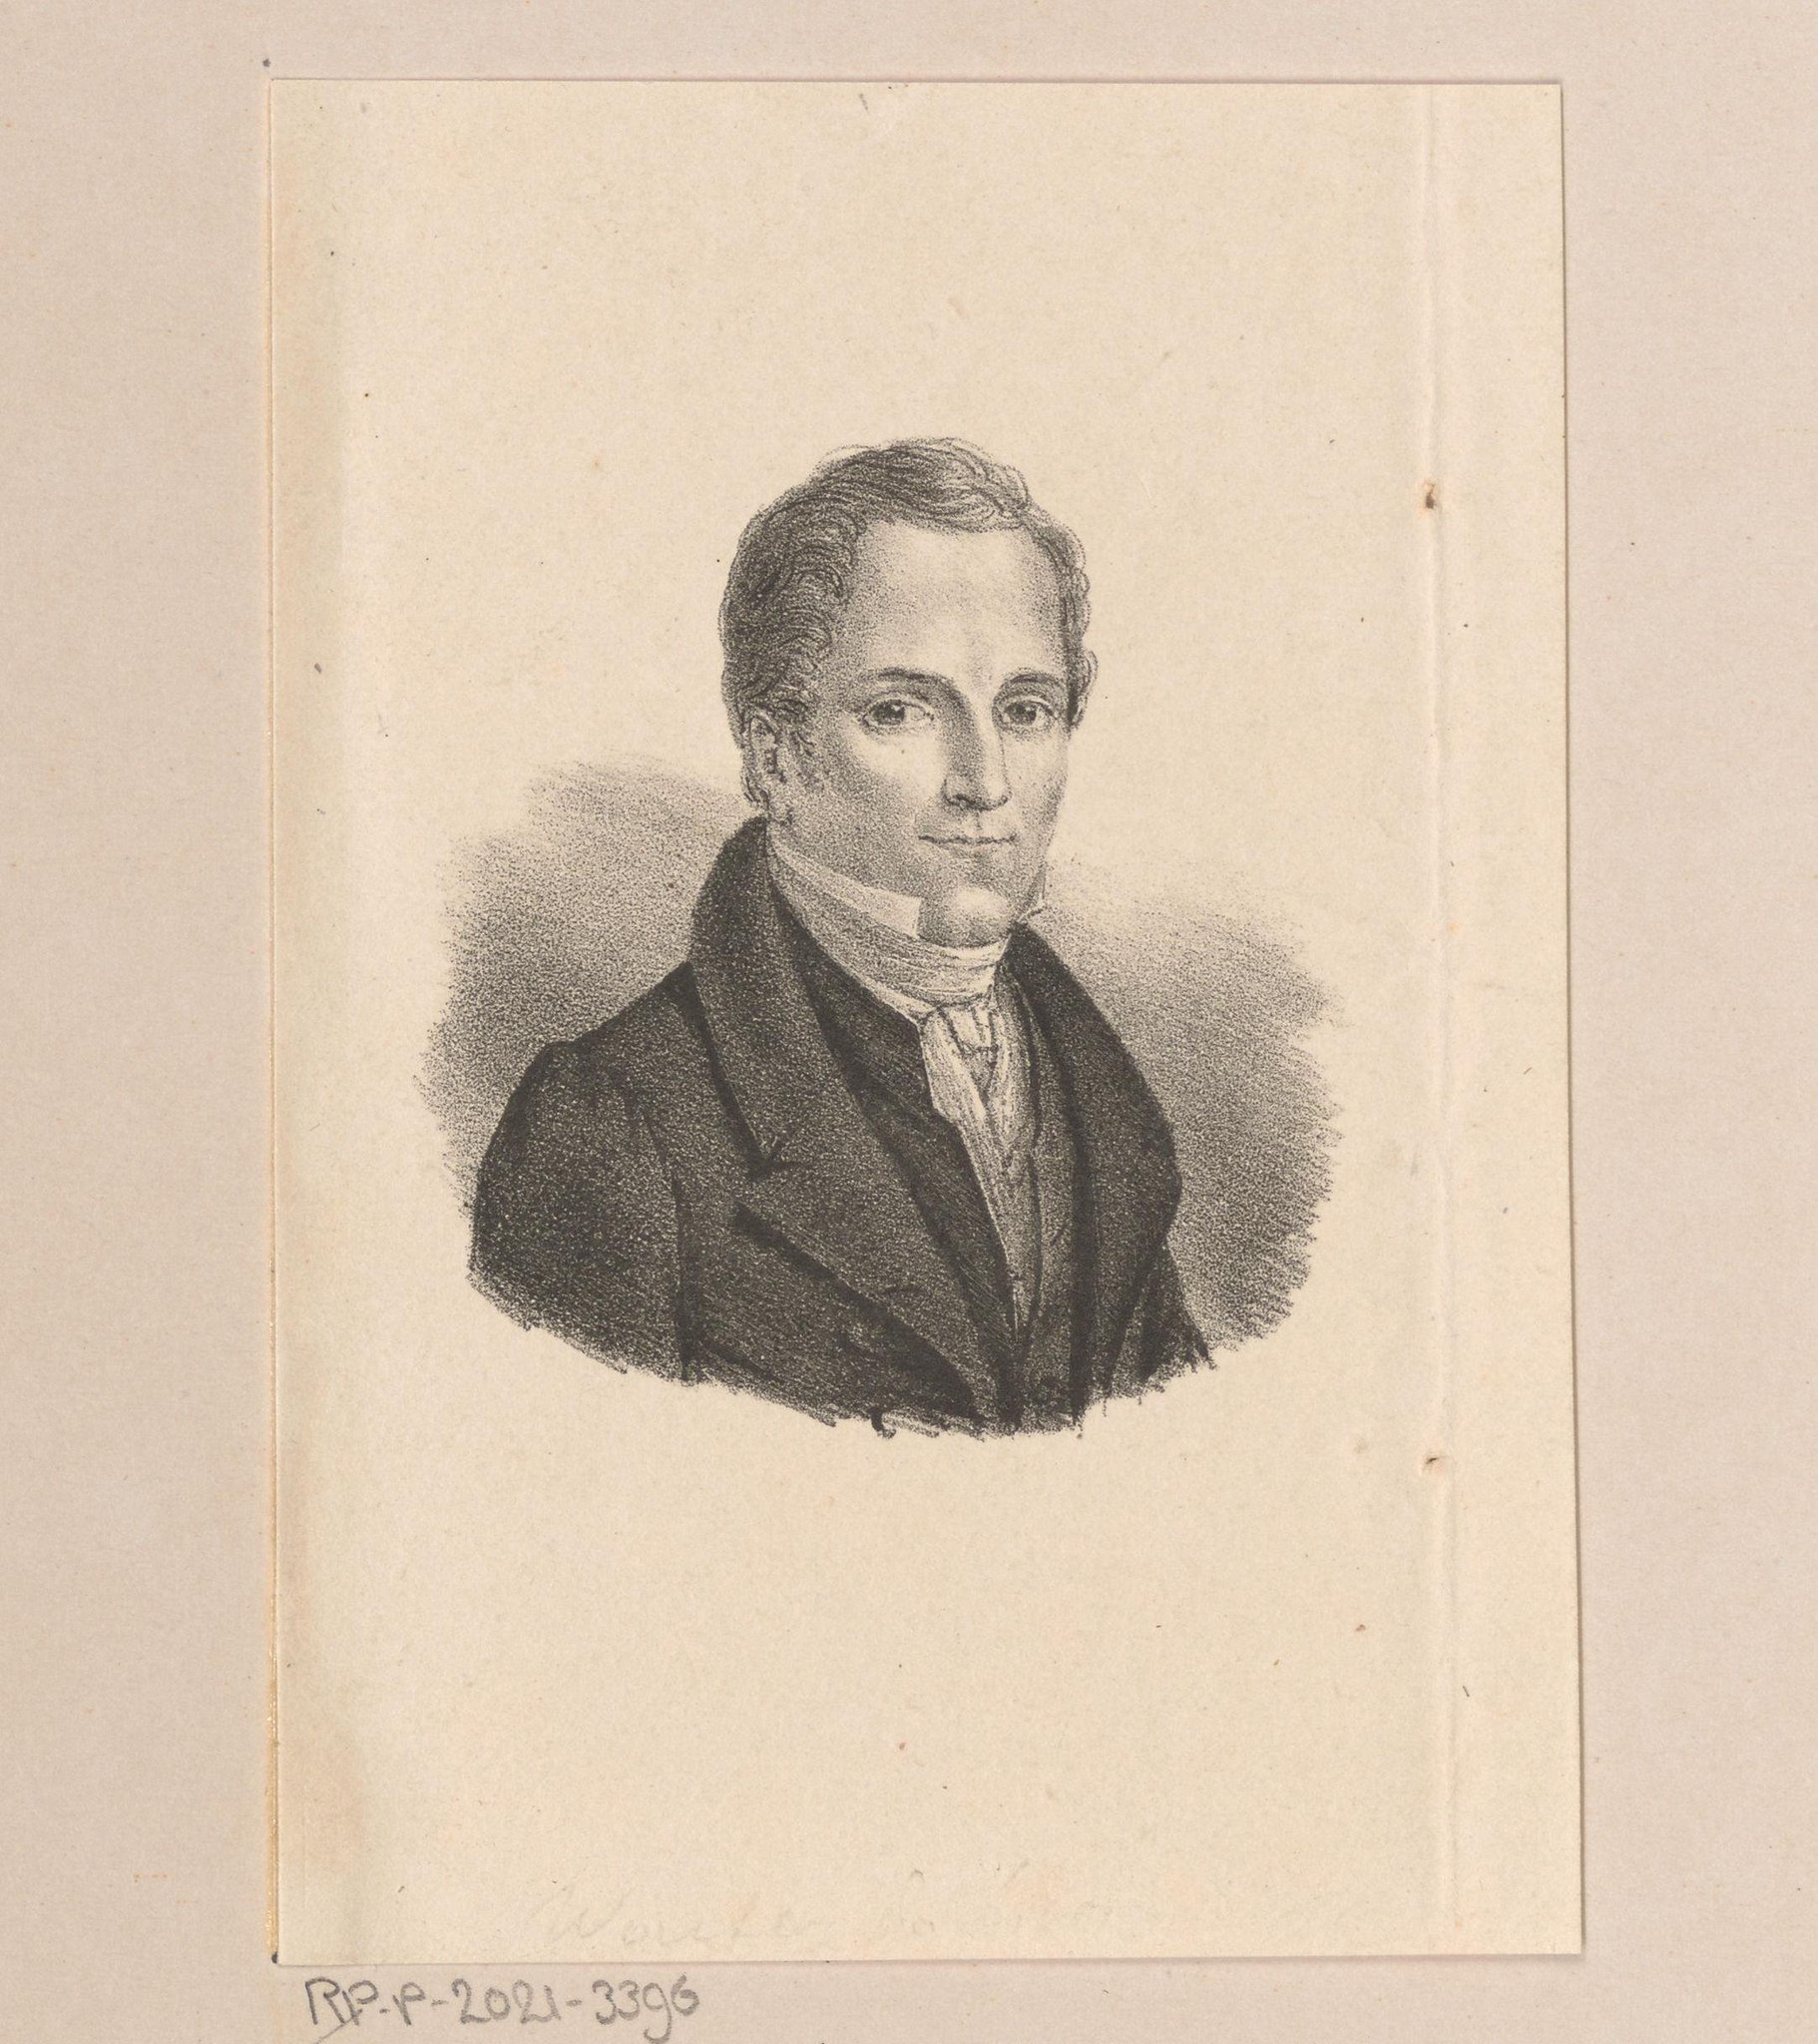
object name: print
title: Portret van Wouter de Kroes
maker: Anonymous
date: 1815-1849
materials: paper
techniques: lithograph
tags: historical persons